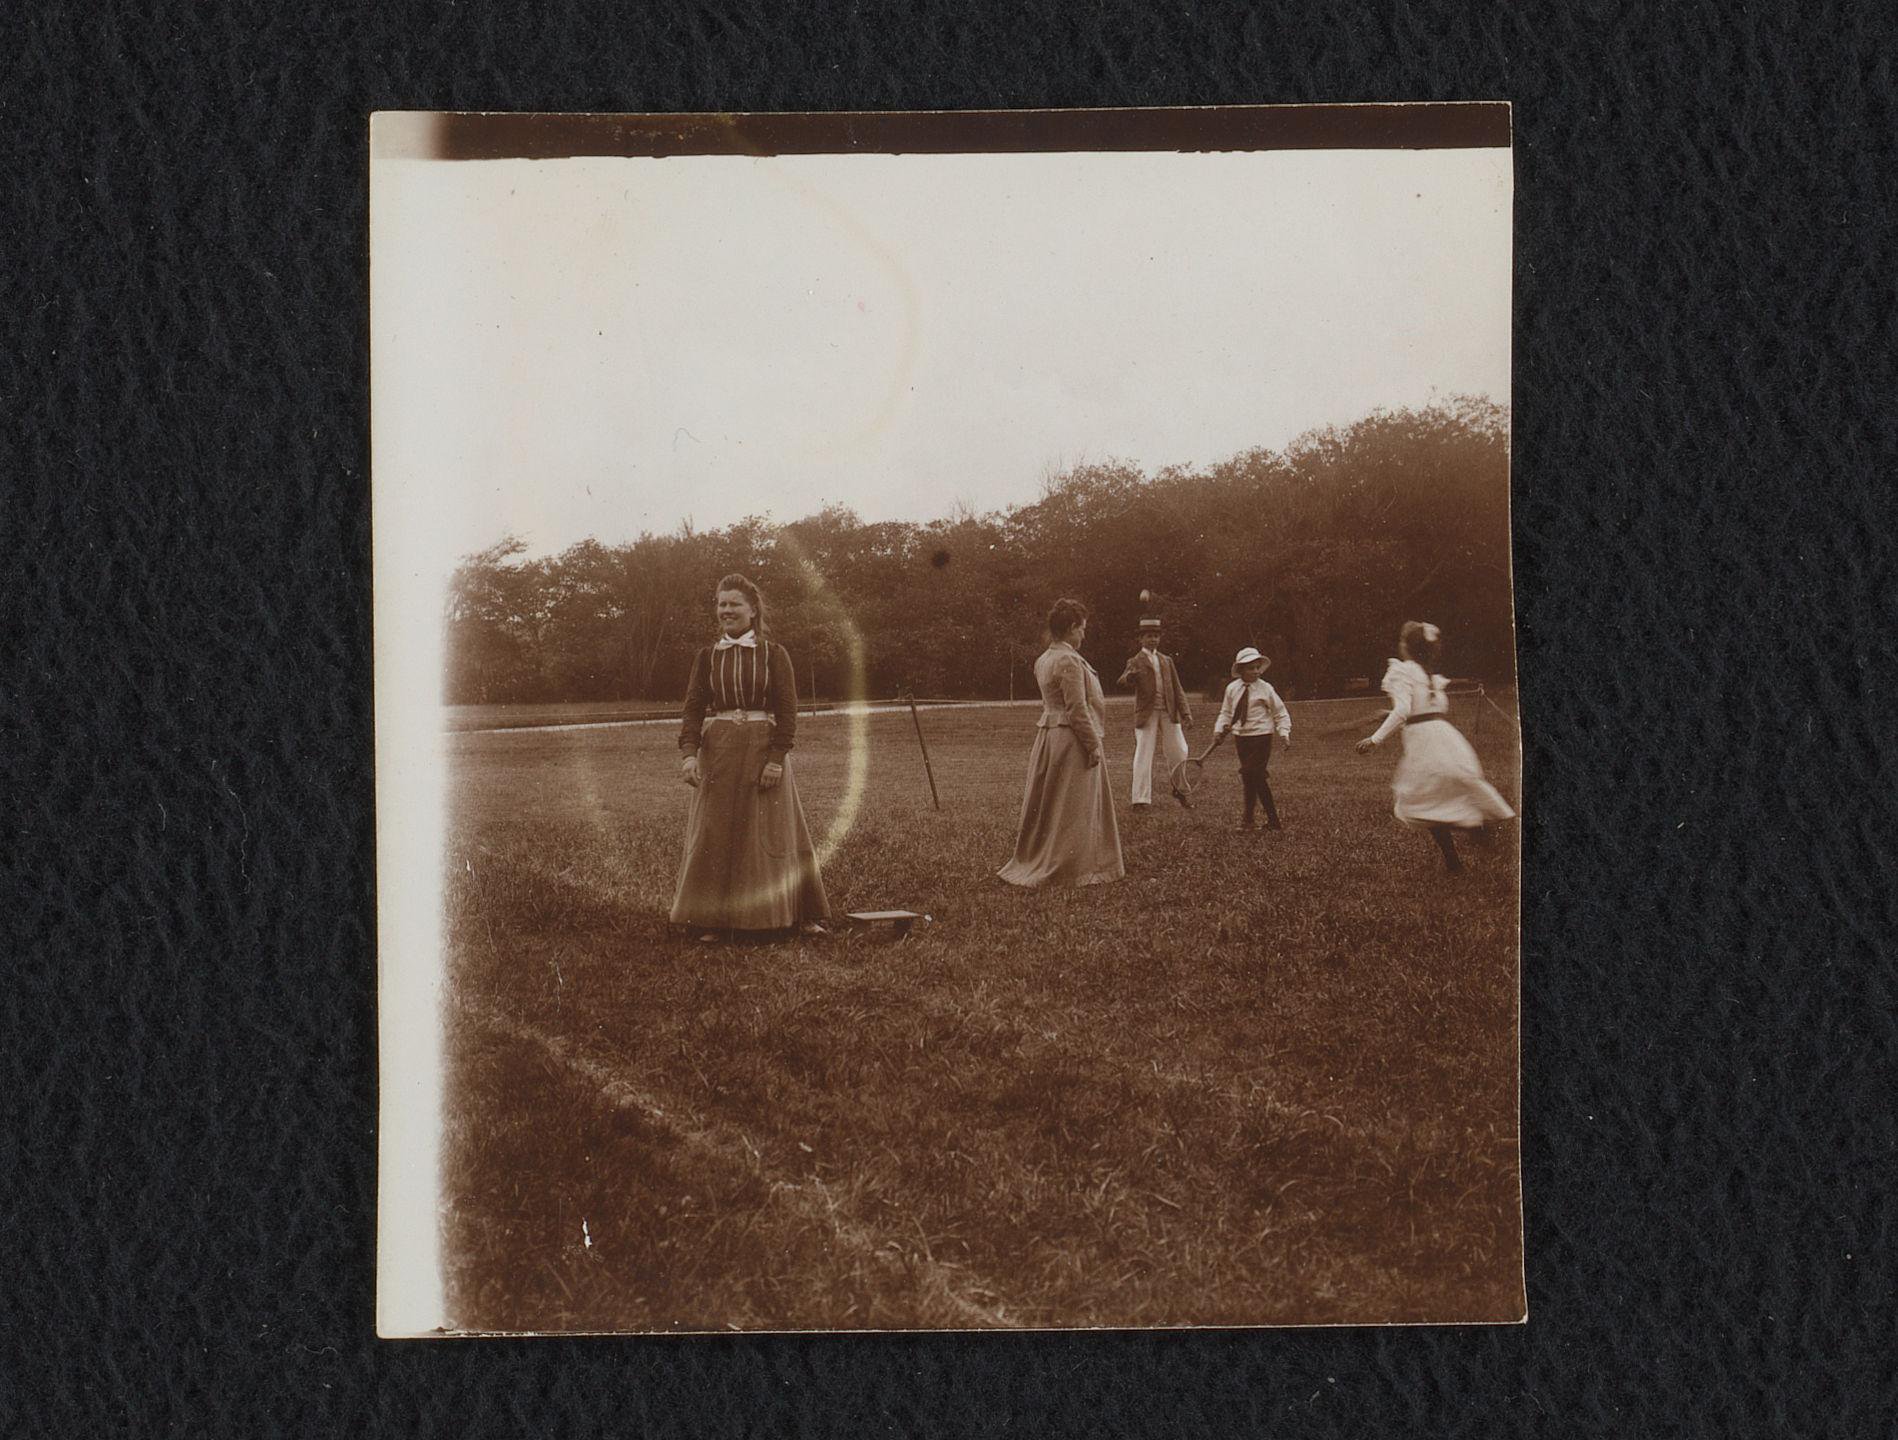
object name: photograph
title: Gezin van August Kessler op een grasveld, met An, Margo, Dolph, Jan en Go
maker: jean baptiste august kessler (1853-1900)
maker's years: 1853-1900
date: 1898-1900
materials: paper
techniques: collodion silver print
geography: netherlands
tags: johan herman kessler (jan), batavia, geldolph adriaan kessler (dolph), margaretha jacoba johanna kessler-de lange (margo), park, family life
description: Uit envelop van Hendrik A. Matthes (1861 – 1919; Keizersgracht 756, Amsterdam), met opschrift van een van de kinderen van August Kessler (1853-1900): 'Photo's die Papaatje bij zich had.'